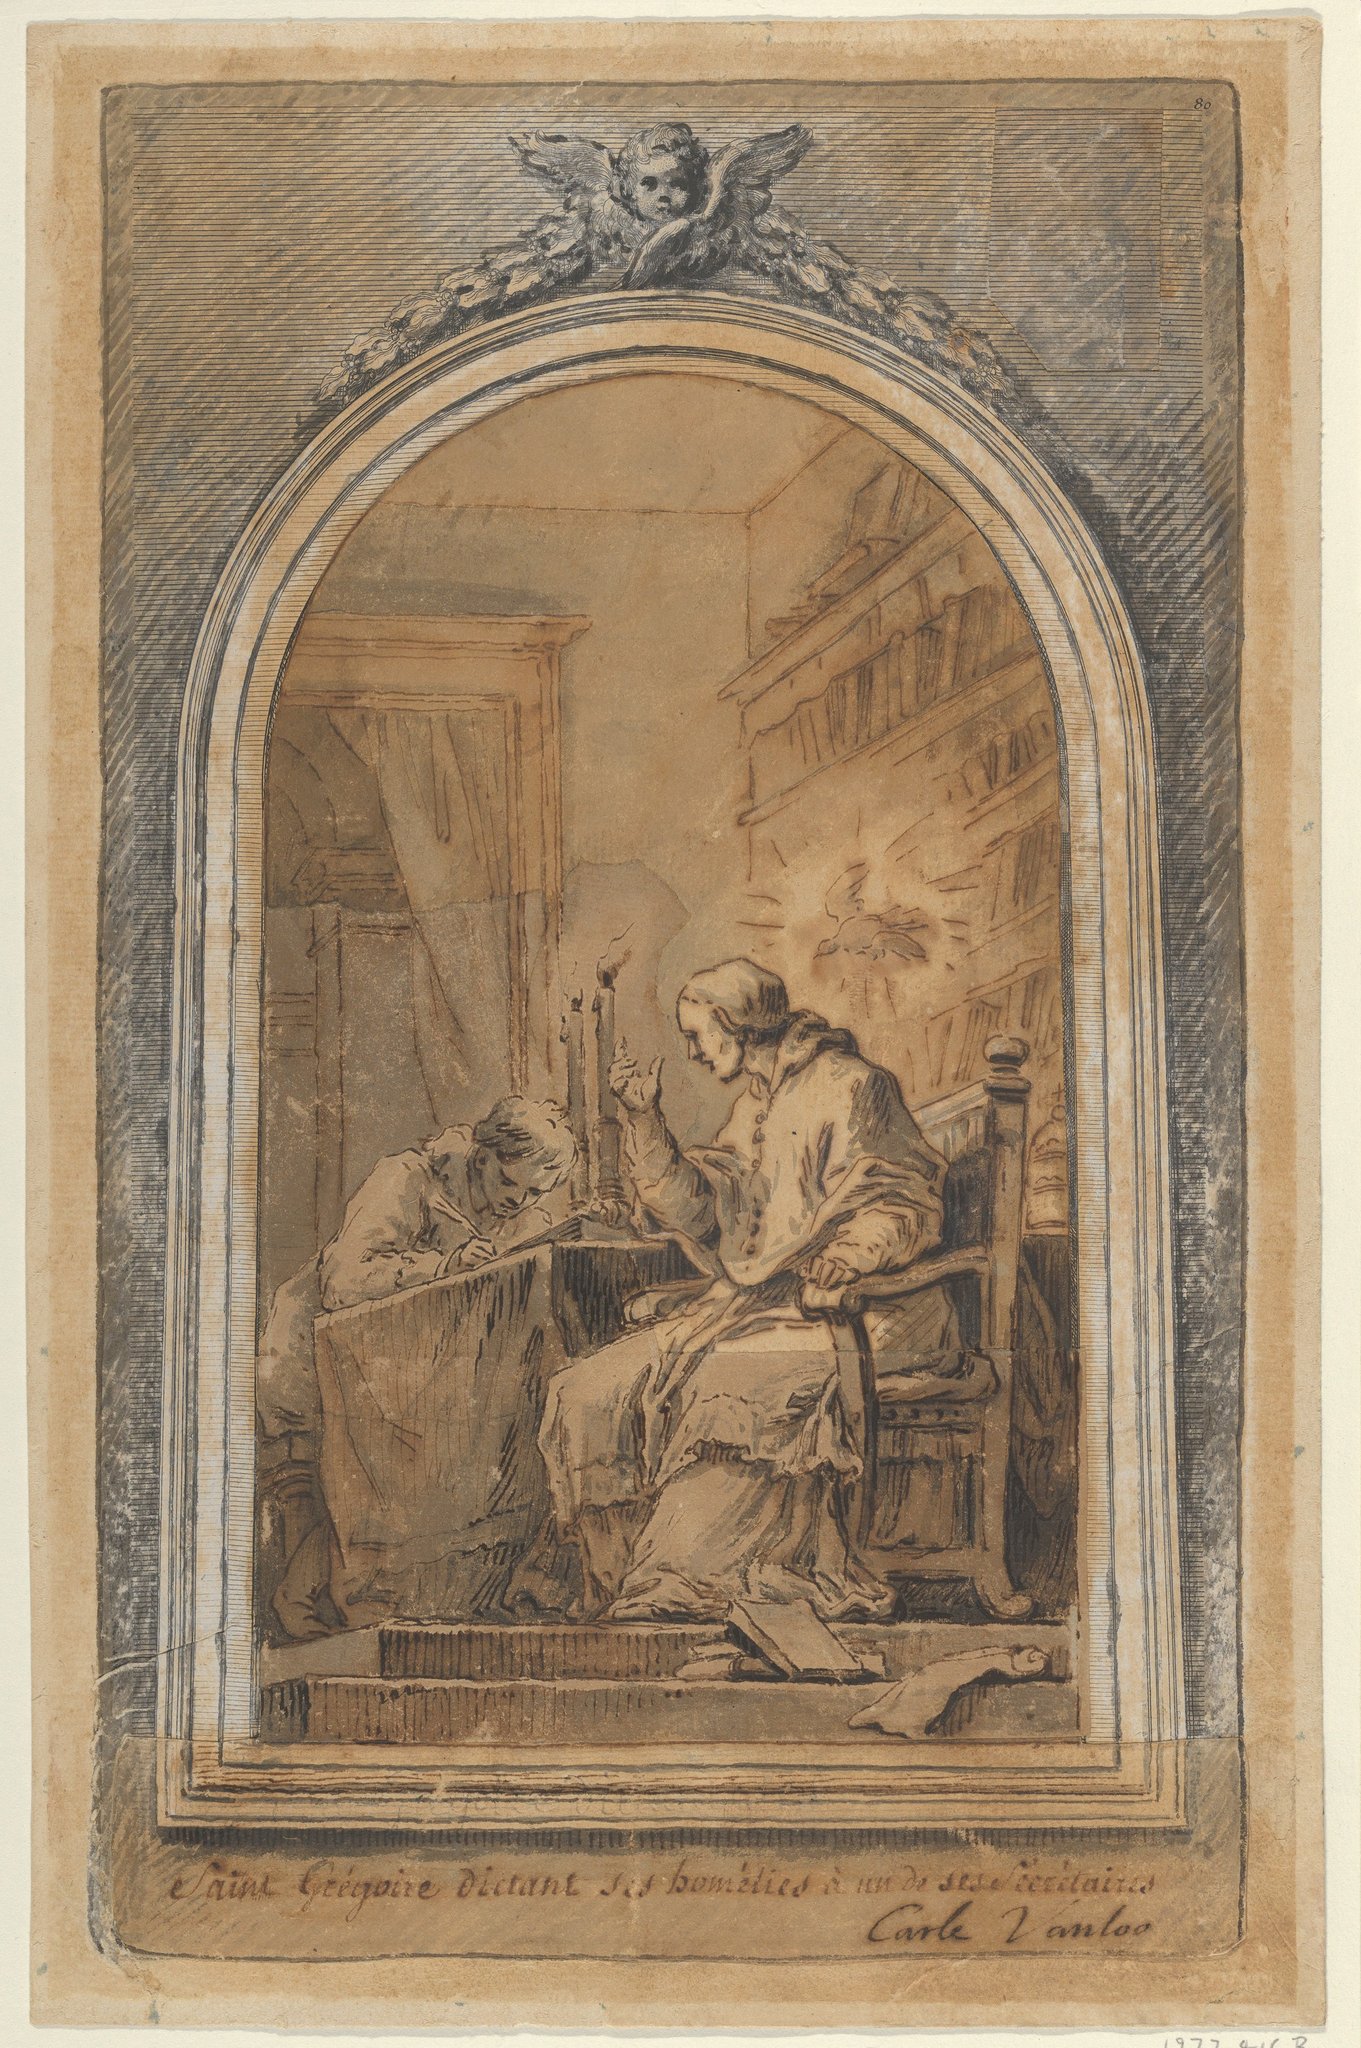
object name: drawing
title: St. Gregory Dictating His Homilies to a Secretary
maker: carle (charles andré) vanloo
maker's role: artist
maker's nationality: french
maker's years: 1705-1765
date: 1701-1800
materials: graphite, ink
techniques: brush, pen, wash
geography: france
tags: men,saints,writing